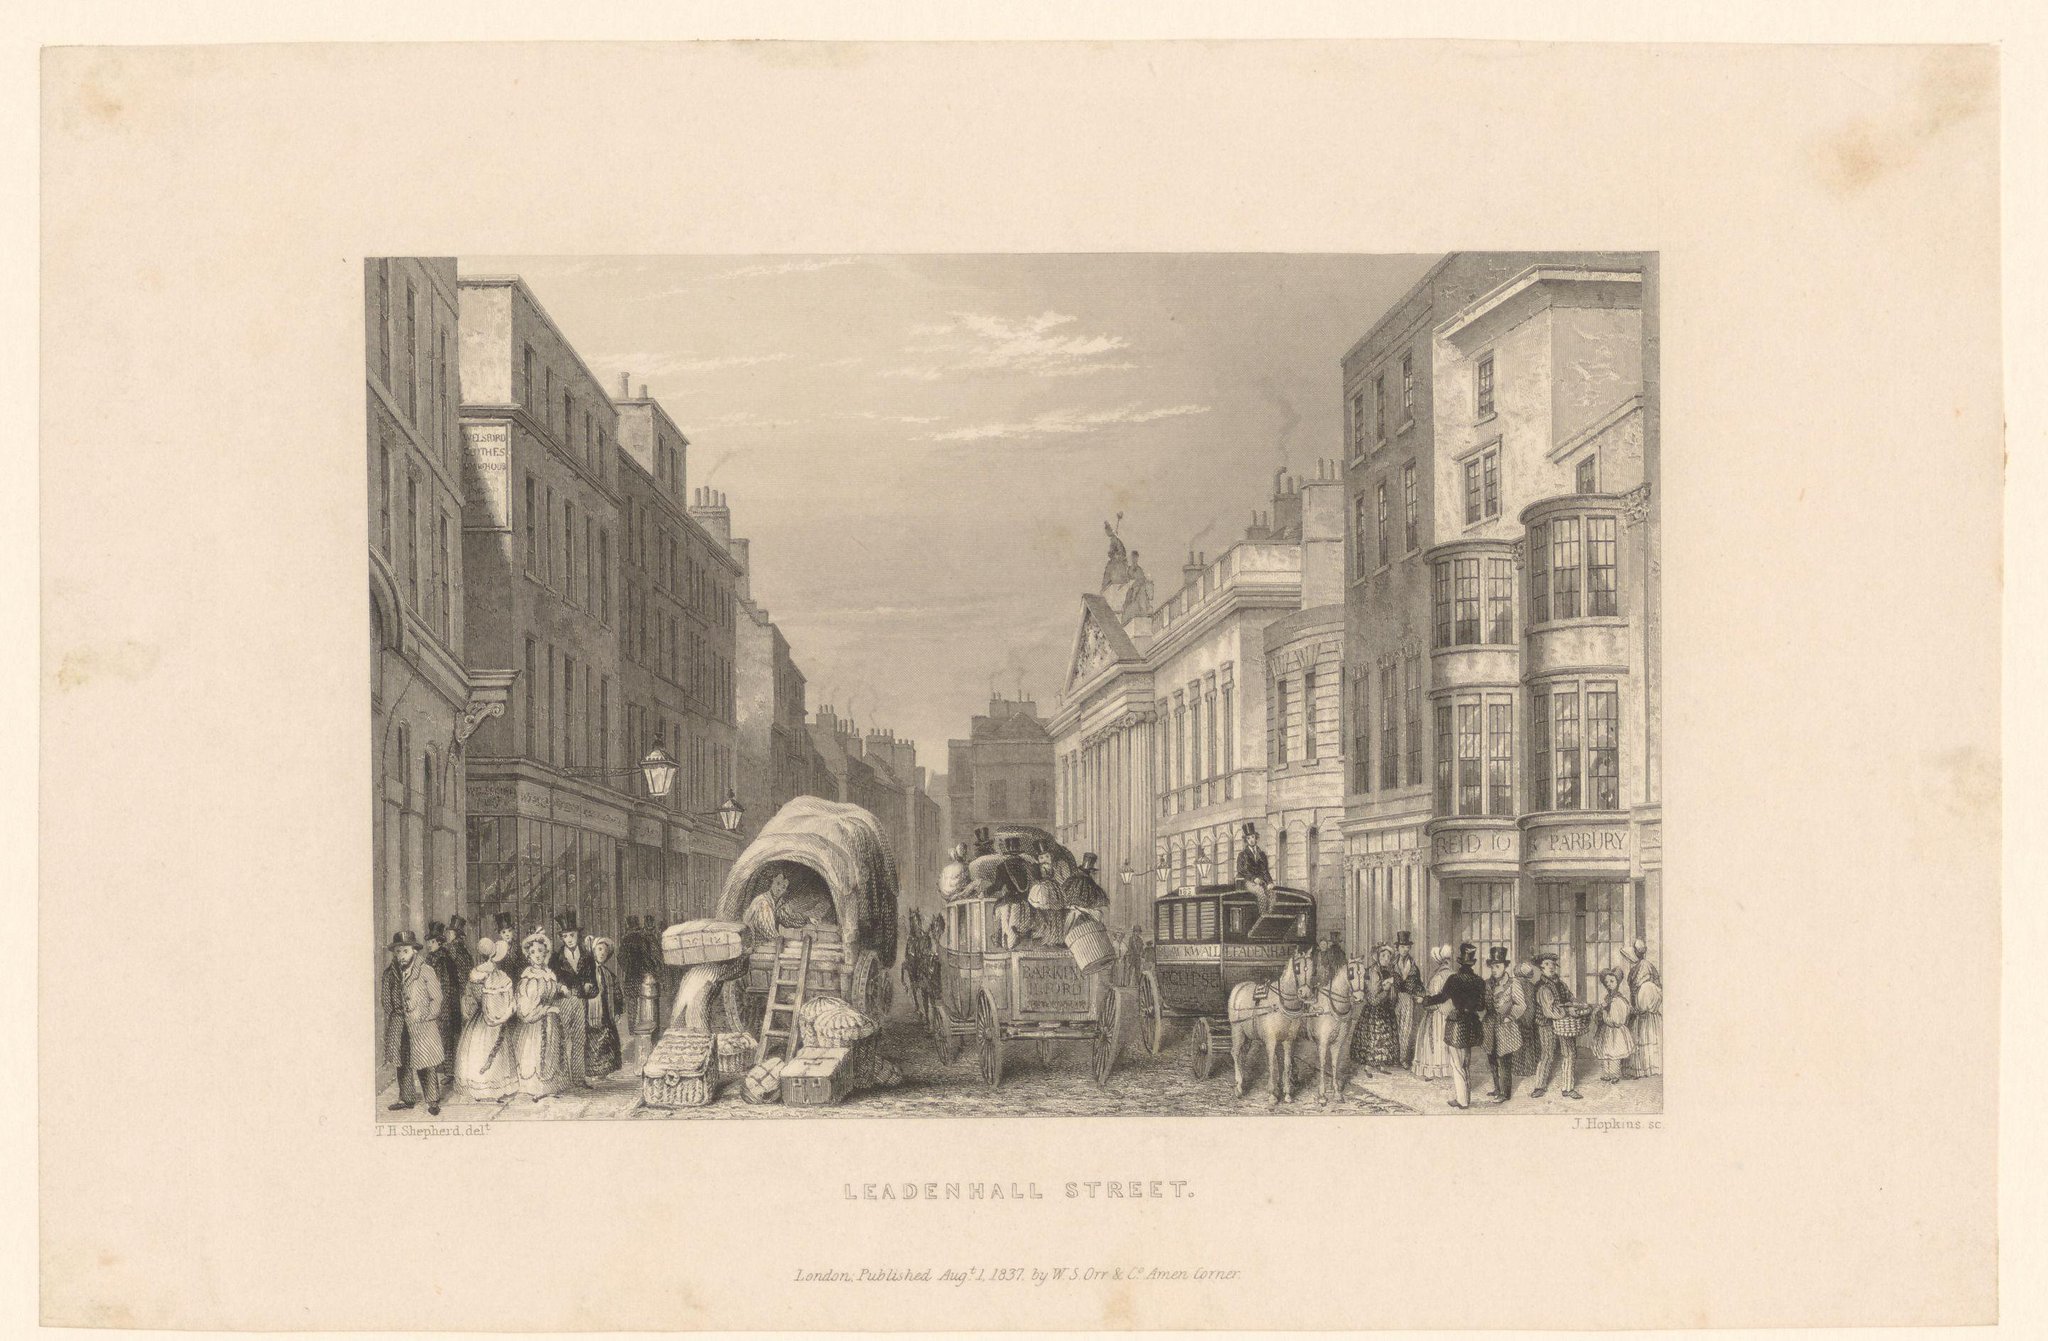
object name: book illustration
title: Leadenhall Street in Londen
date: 1808-1837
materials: paper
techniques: etching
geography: london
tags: four-wheeled, animal-drawn vehicle, e.g.: cab, carriage, coach, street (+ city(-scape) with figures, staffage), london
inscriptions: collector's mark: Lugt 2228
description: Prent uit: Wood. History of London (...). Londen: William S. Orr & Co., 1837.